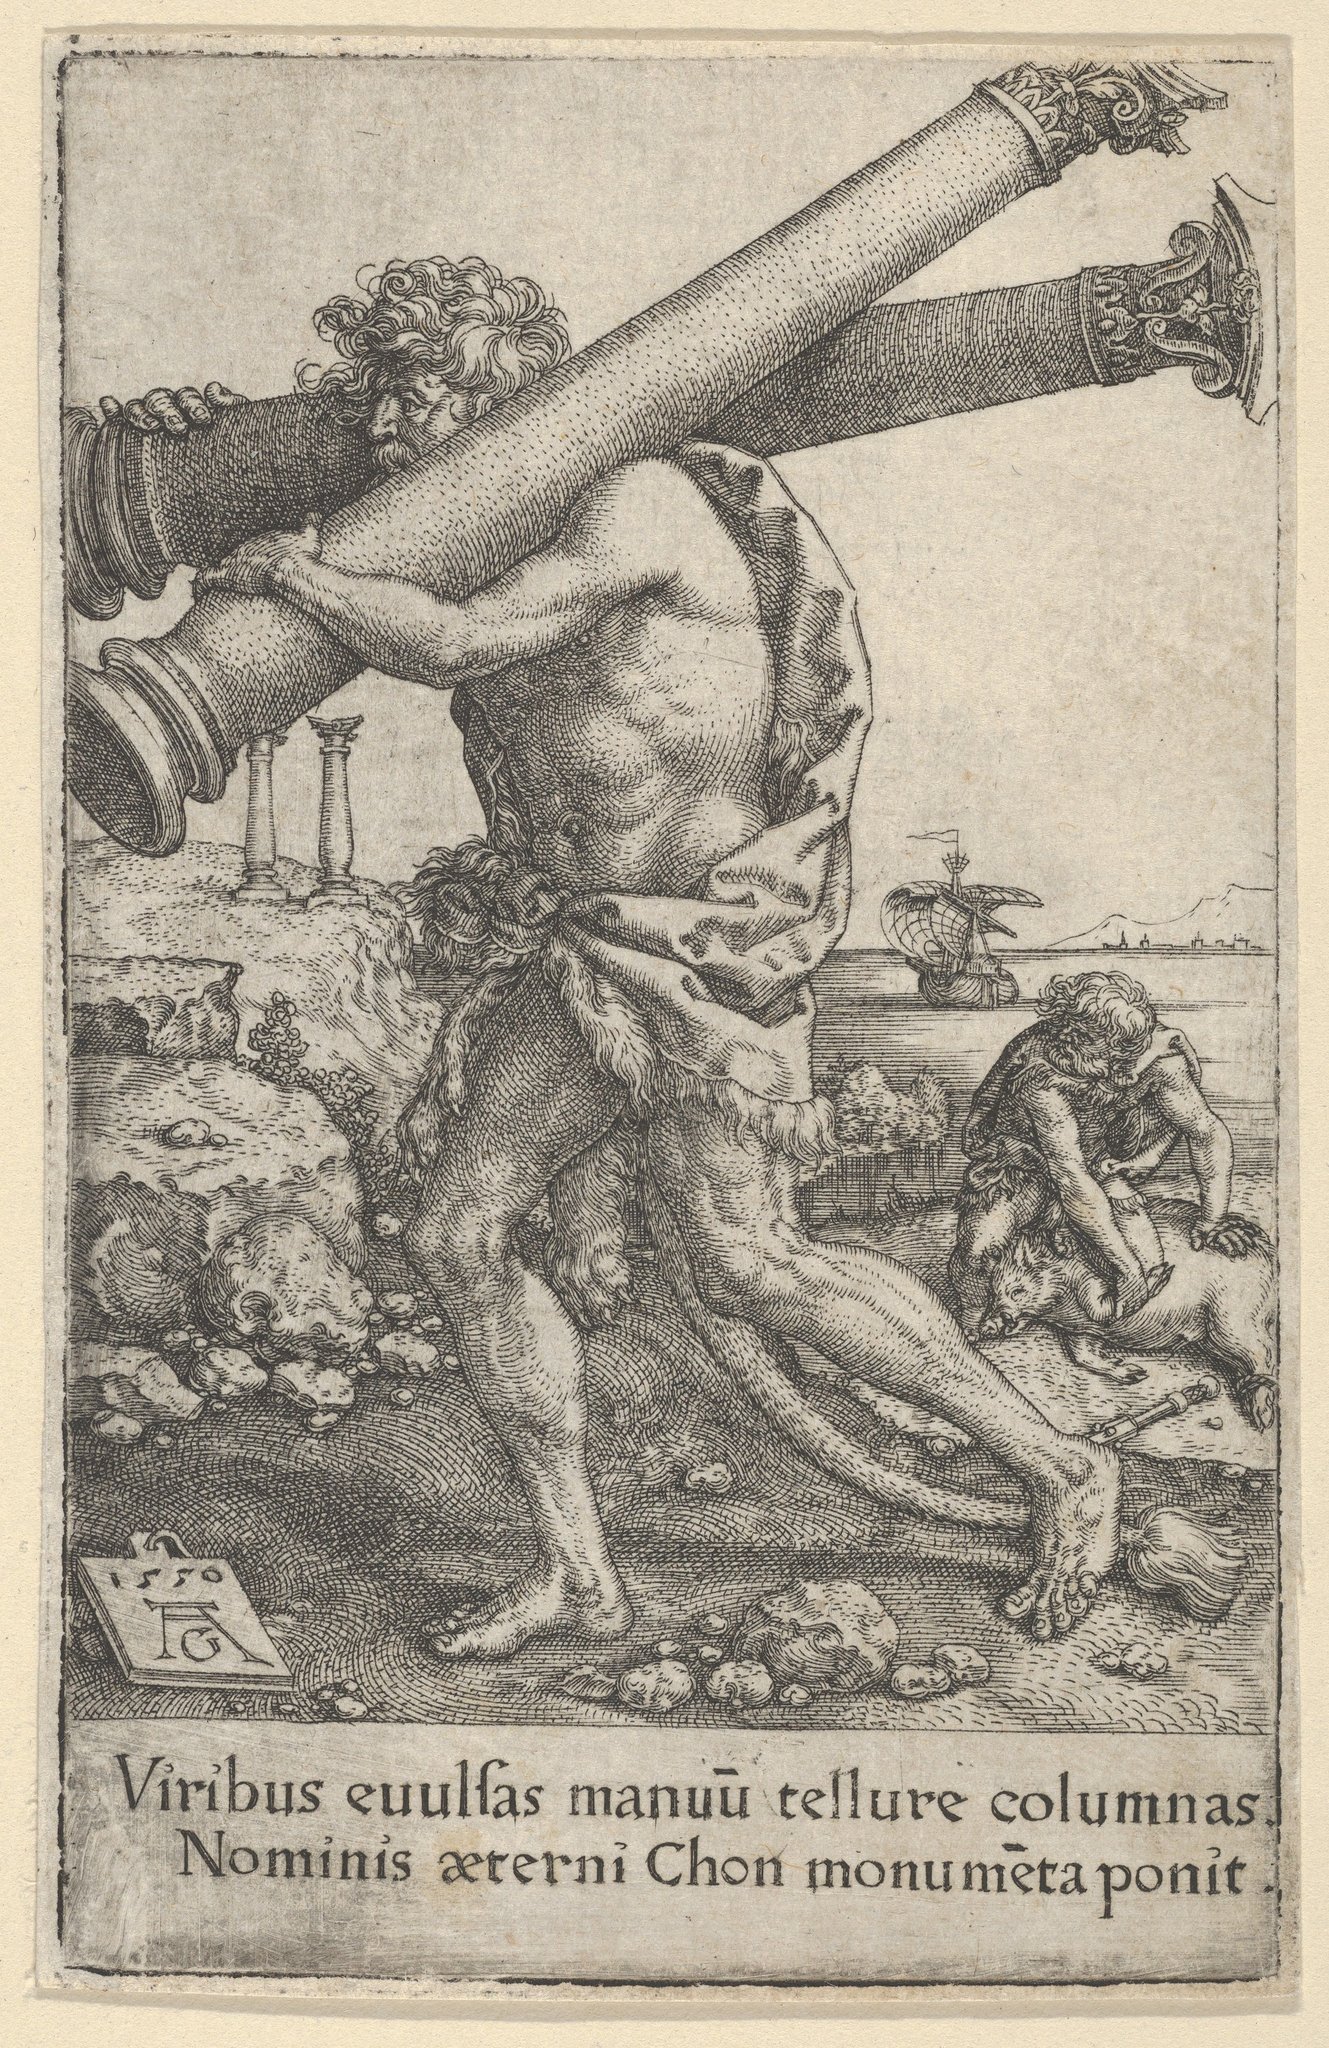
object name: print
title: The Pillars of Hercules, from The Labors of Hercules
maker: heinrich aldegrever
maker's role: artist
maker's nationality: german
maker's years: 1502-1561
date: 1550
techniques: engraving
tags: columns,men,hercules,boars